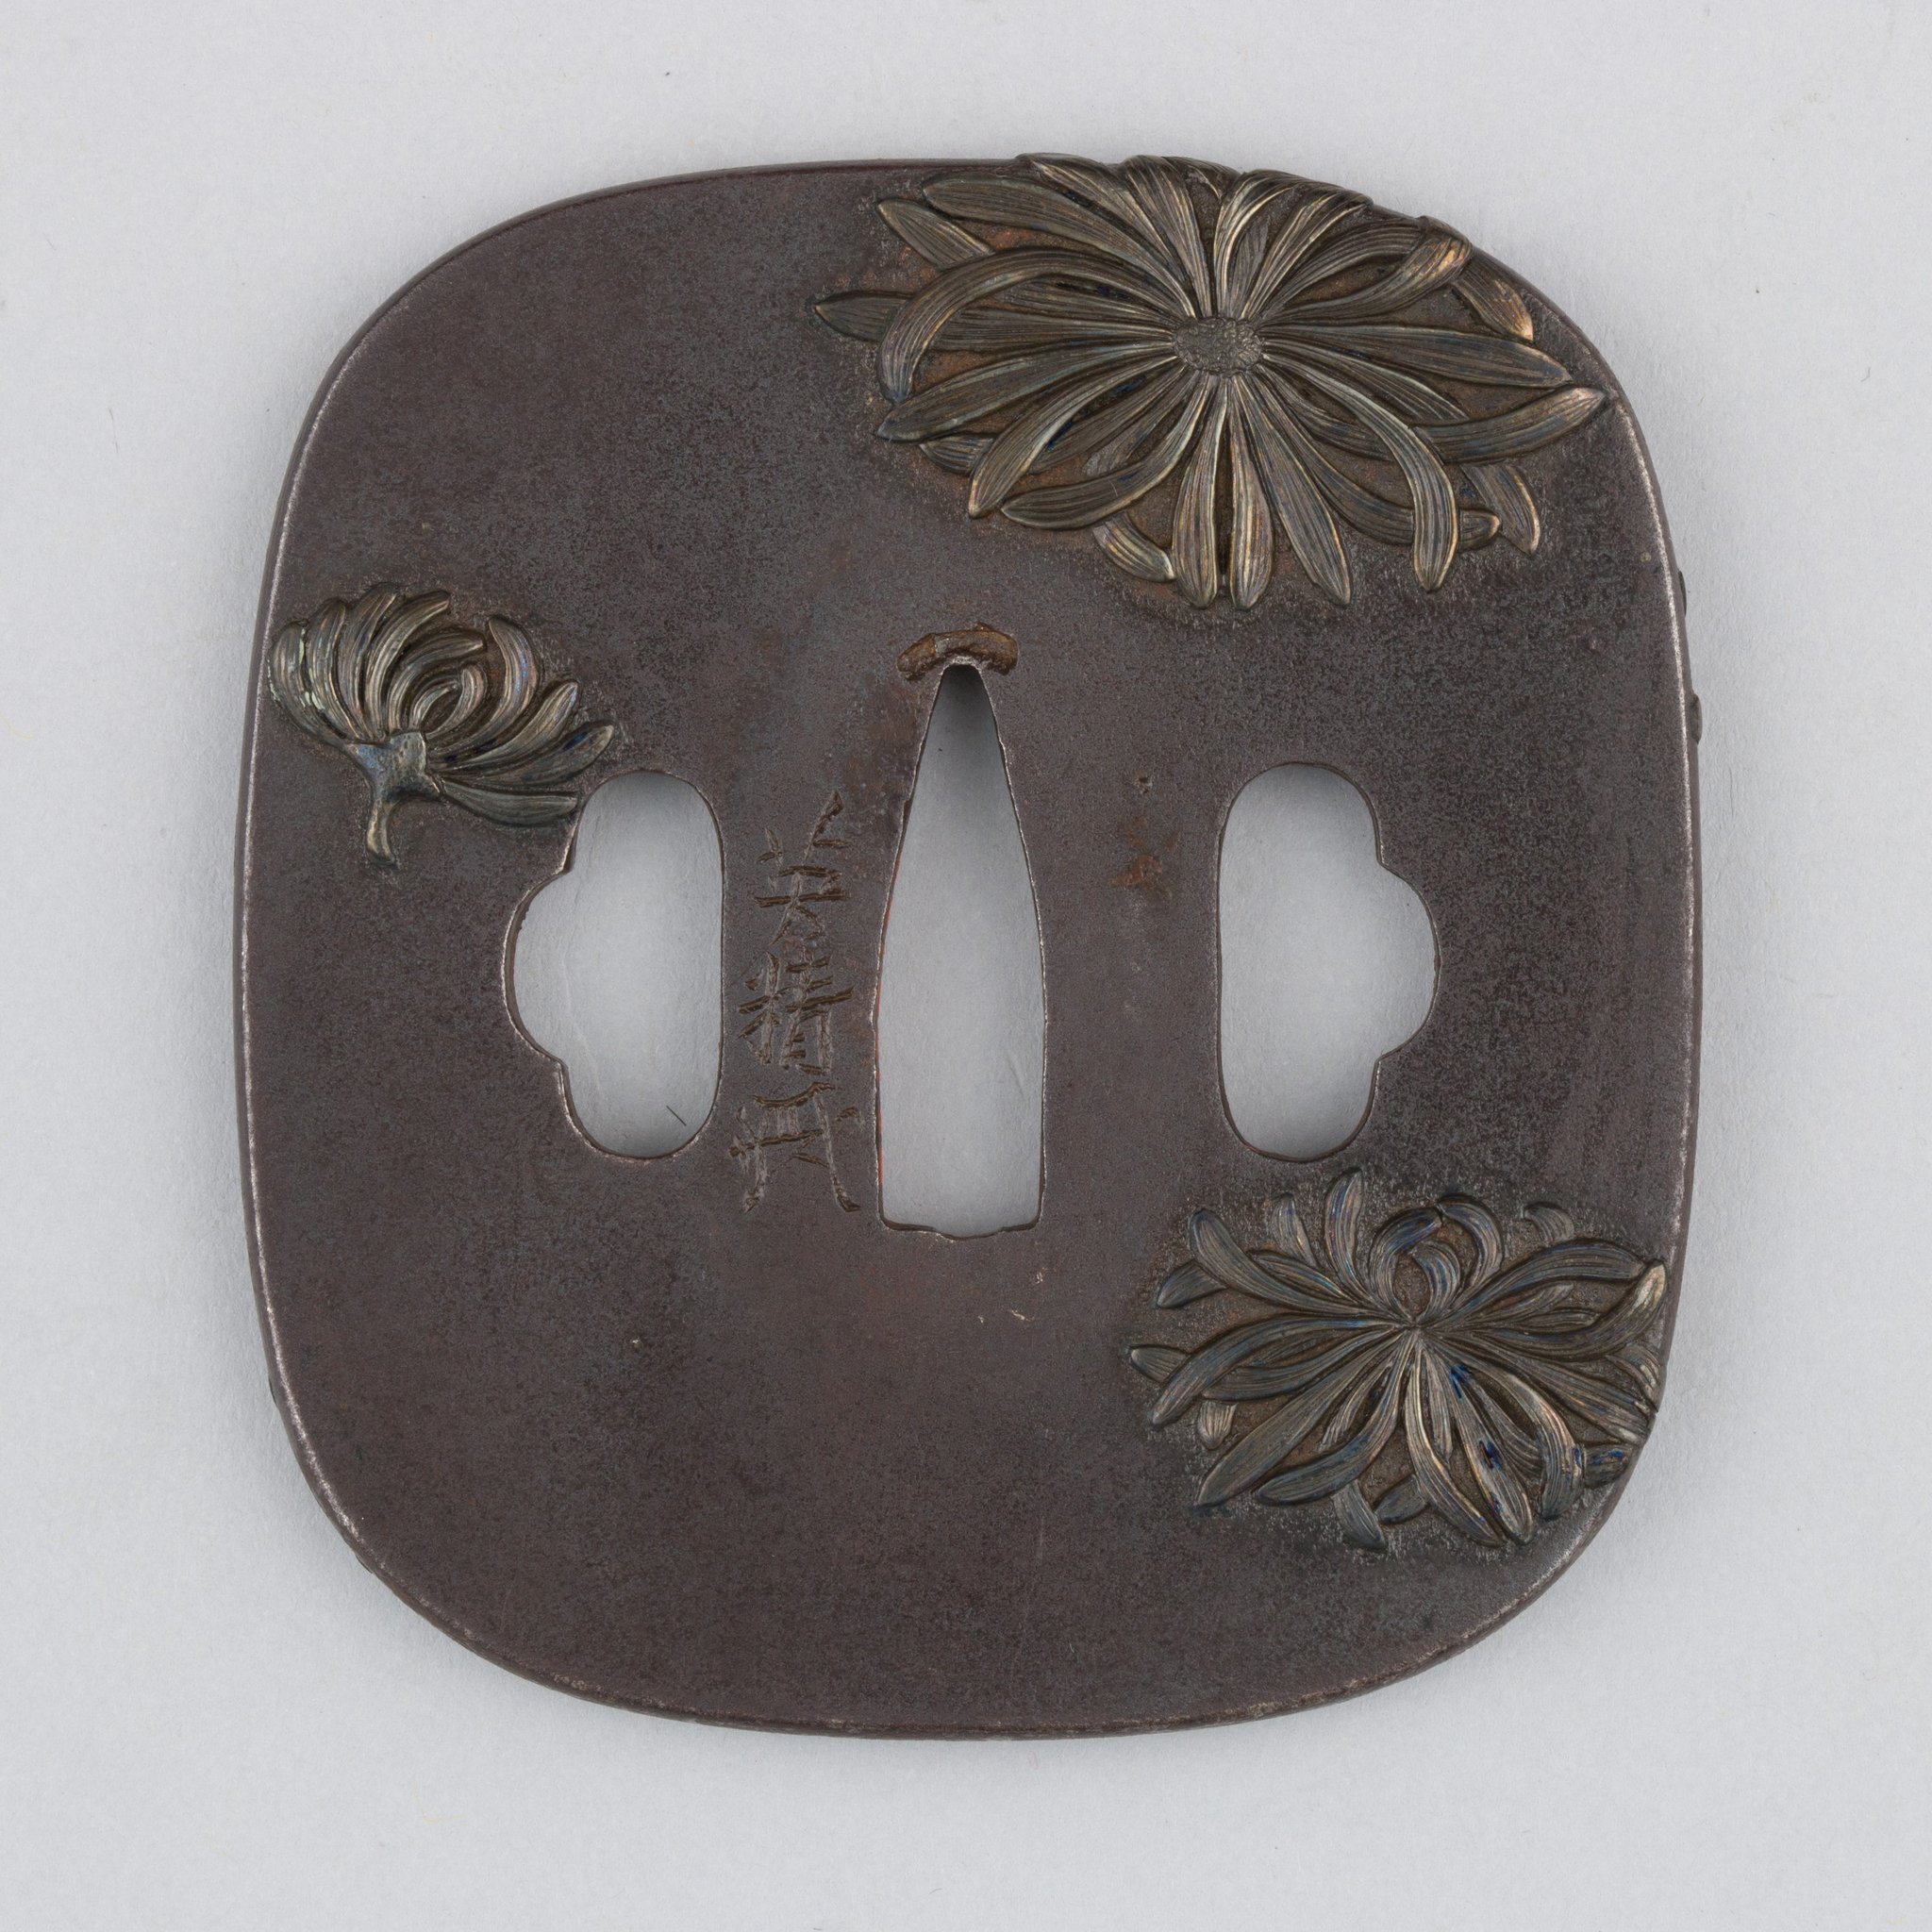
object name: sword guard tsuba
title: Sword Guard (Tsuba)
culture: japanese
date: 1701-1800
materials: copper, iron, silver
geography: japan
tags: flowers